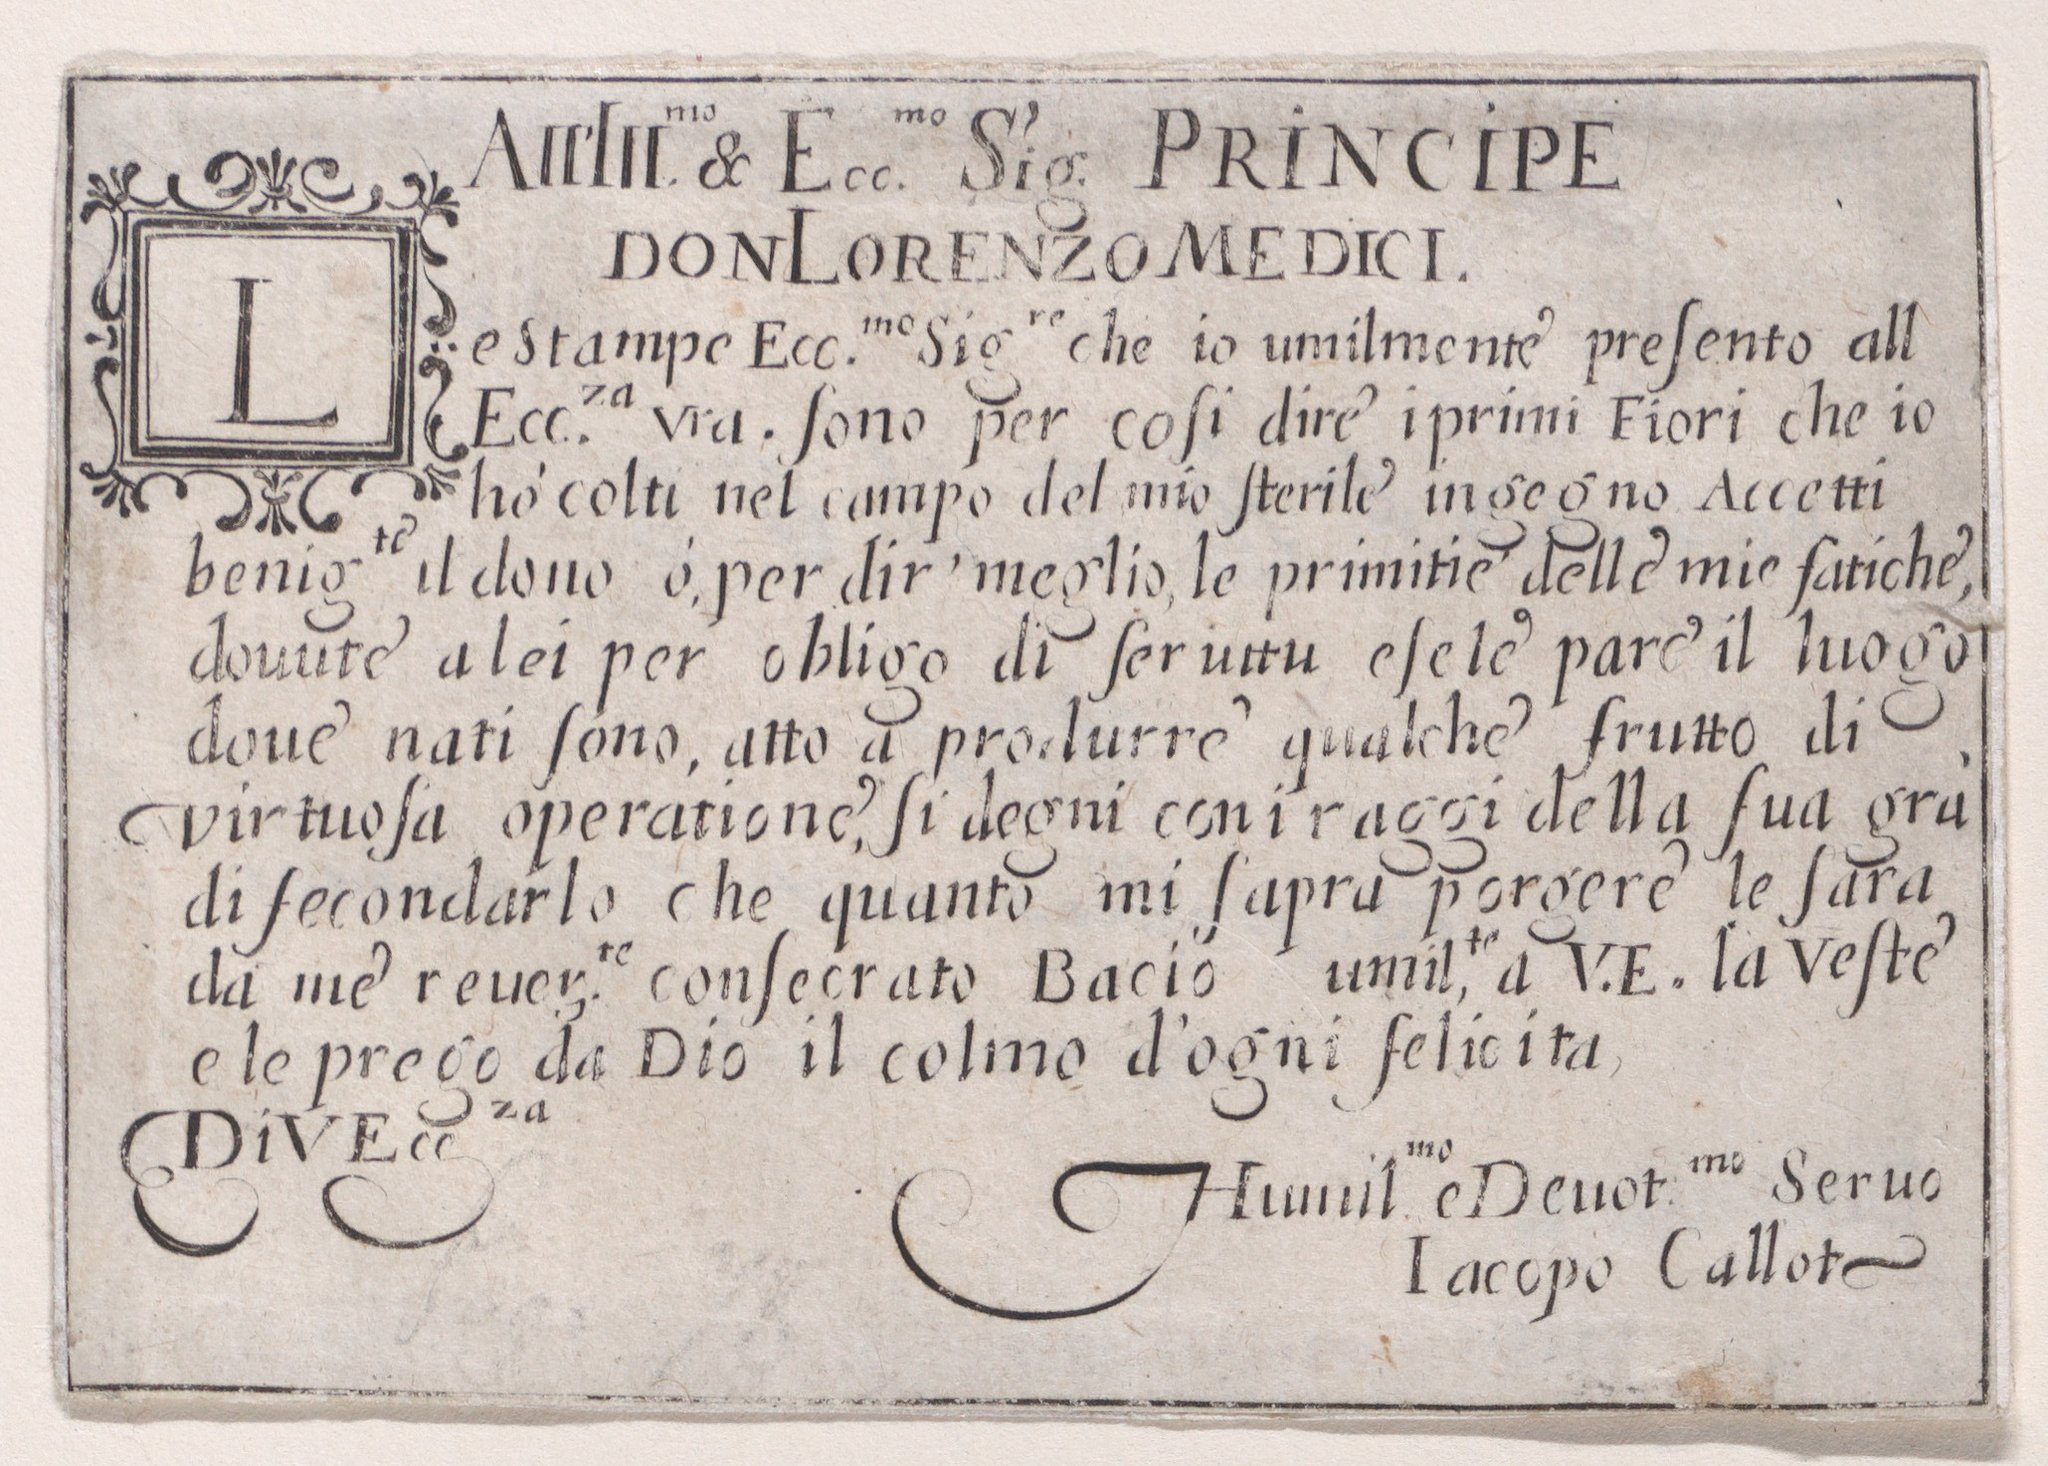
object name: print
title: Dedication to Lorenzo de'Medici, from "Les Caprices" Series B, The Nancy Set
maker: jacques callot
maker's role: artist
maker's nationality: french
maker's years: 1592-1635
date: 1617-1620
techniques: etching